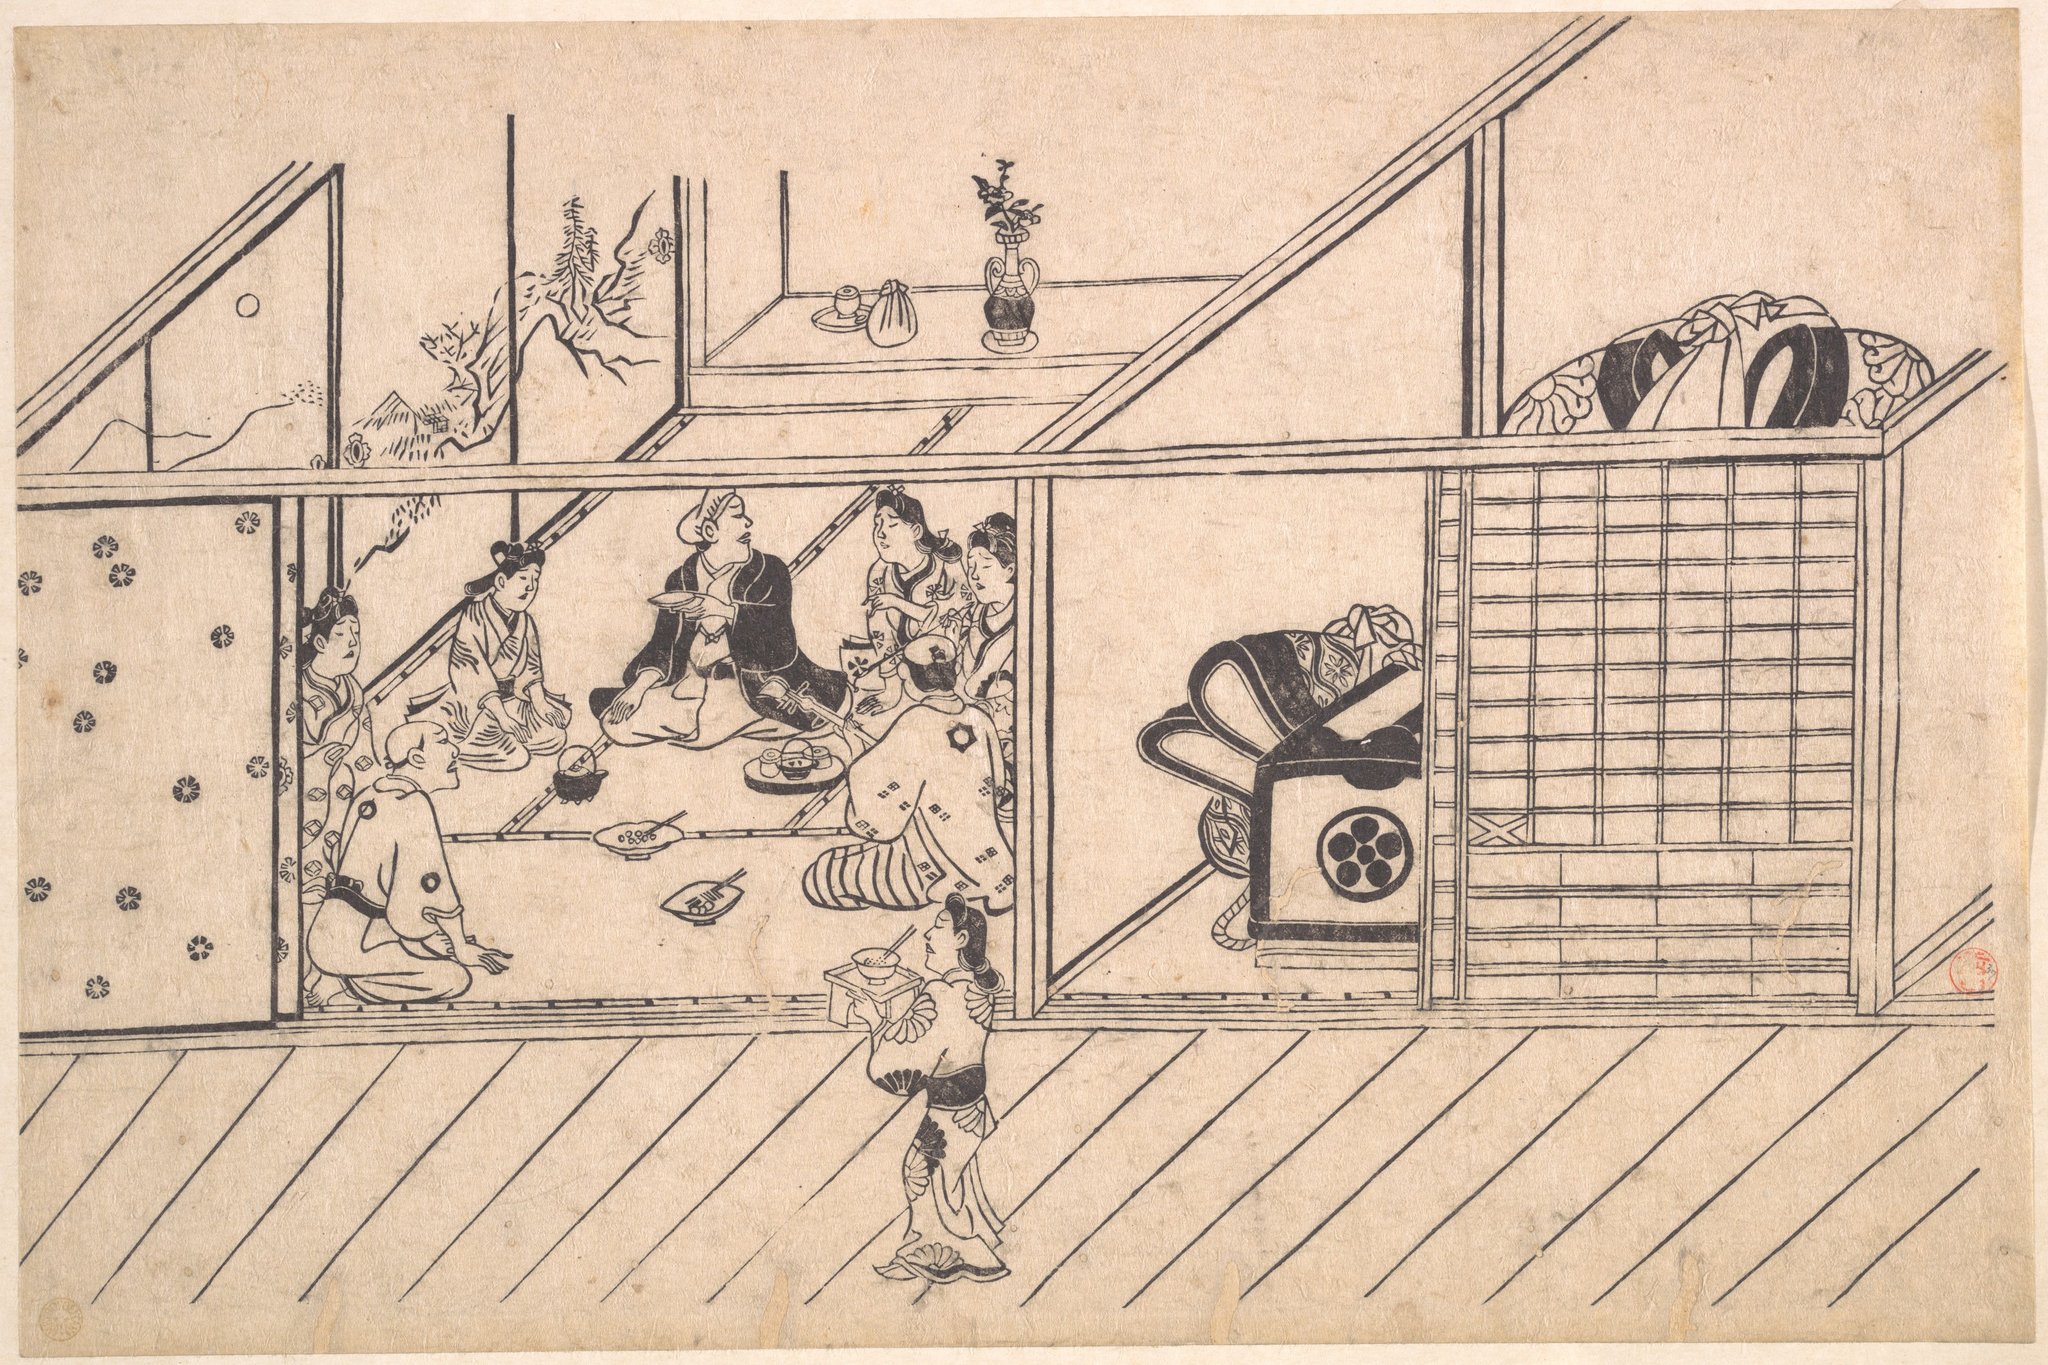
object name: print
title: A Banquet in a Joroya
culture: japanese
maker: hishikawa moronobu 菱川師宣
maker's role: artist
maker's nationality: japanese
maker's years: 1618-1694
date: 1680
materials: ink, paper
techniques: woodblock print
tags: men,women,dining